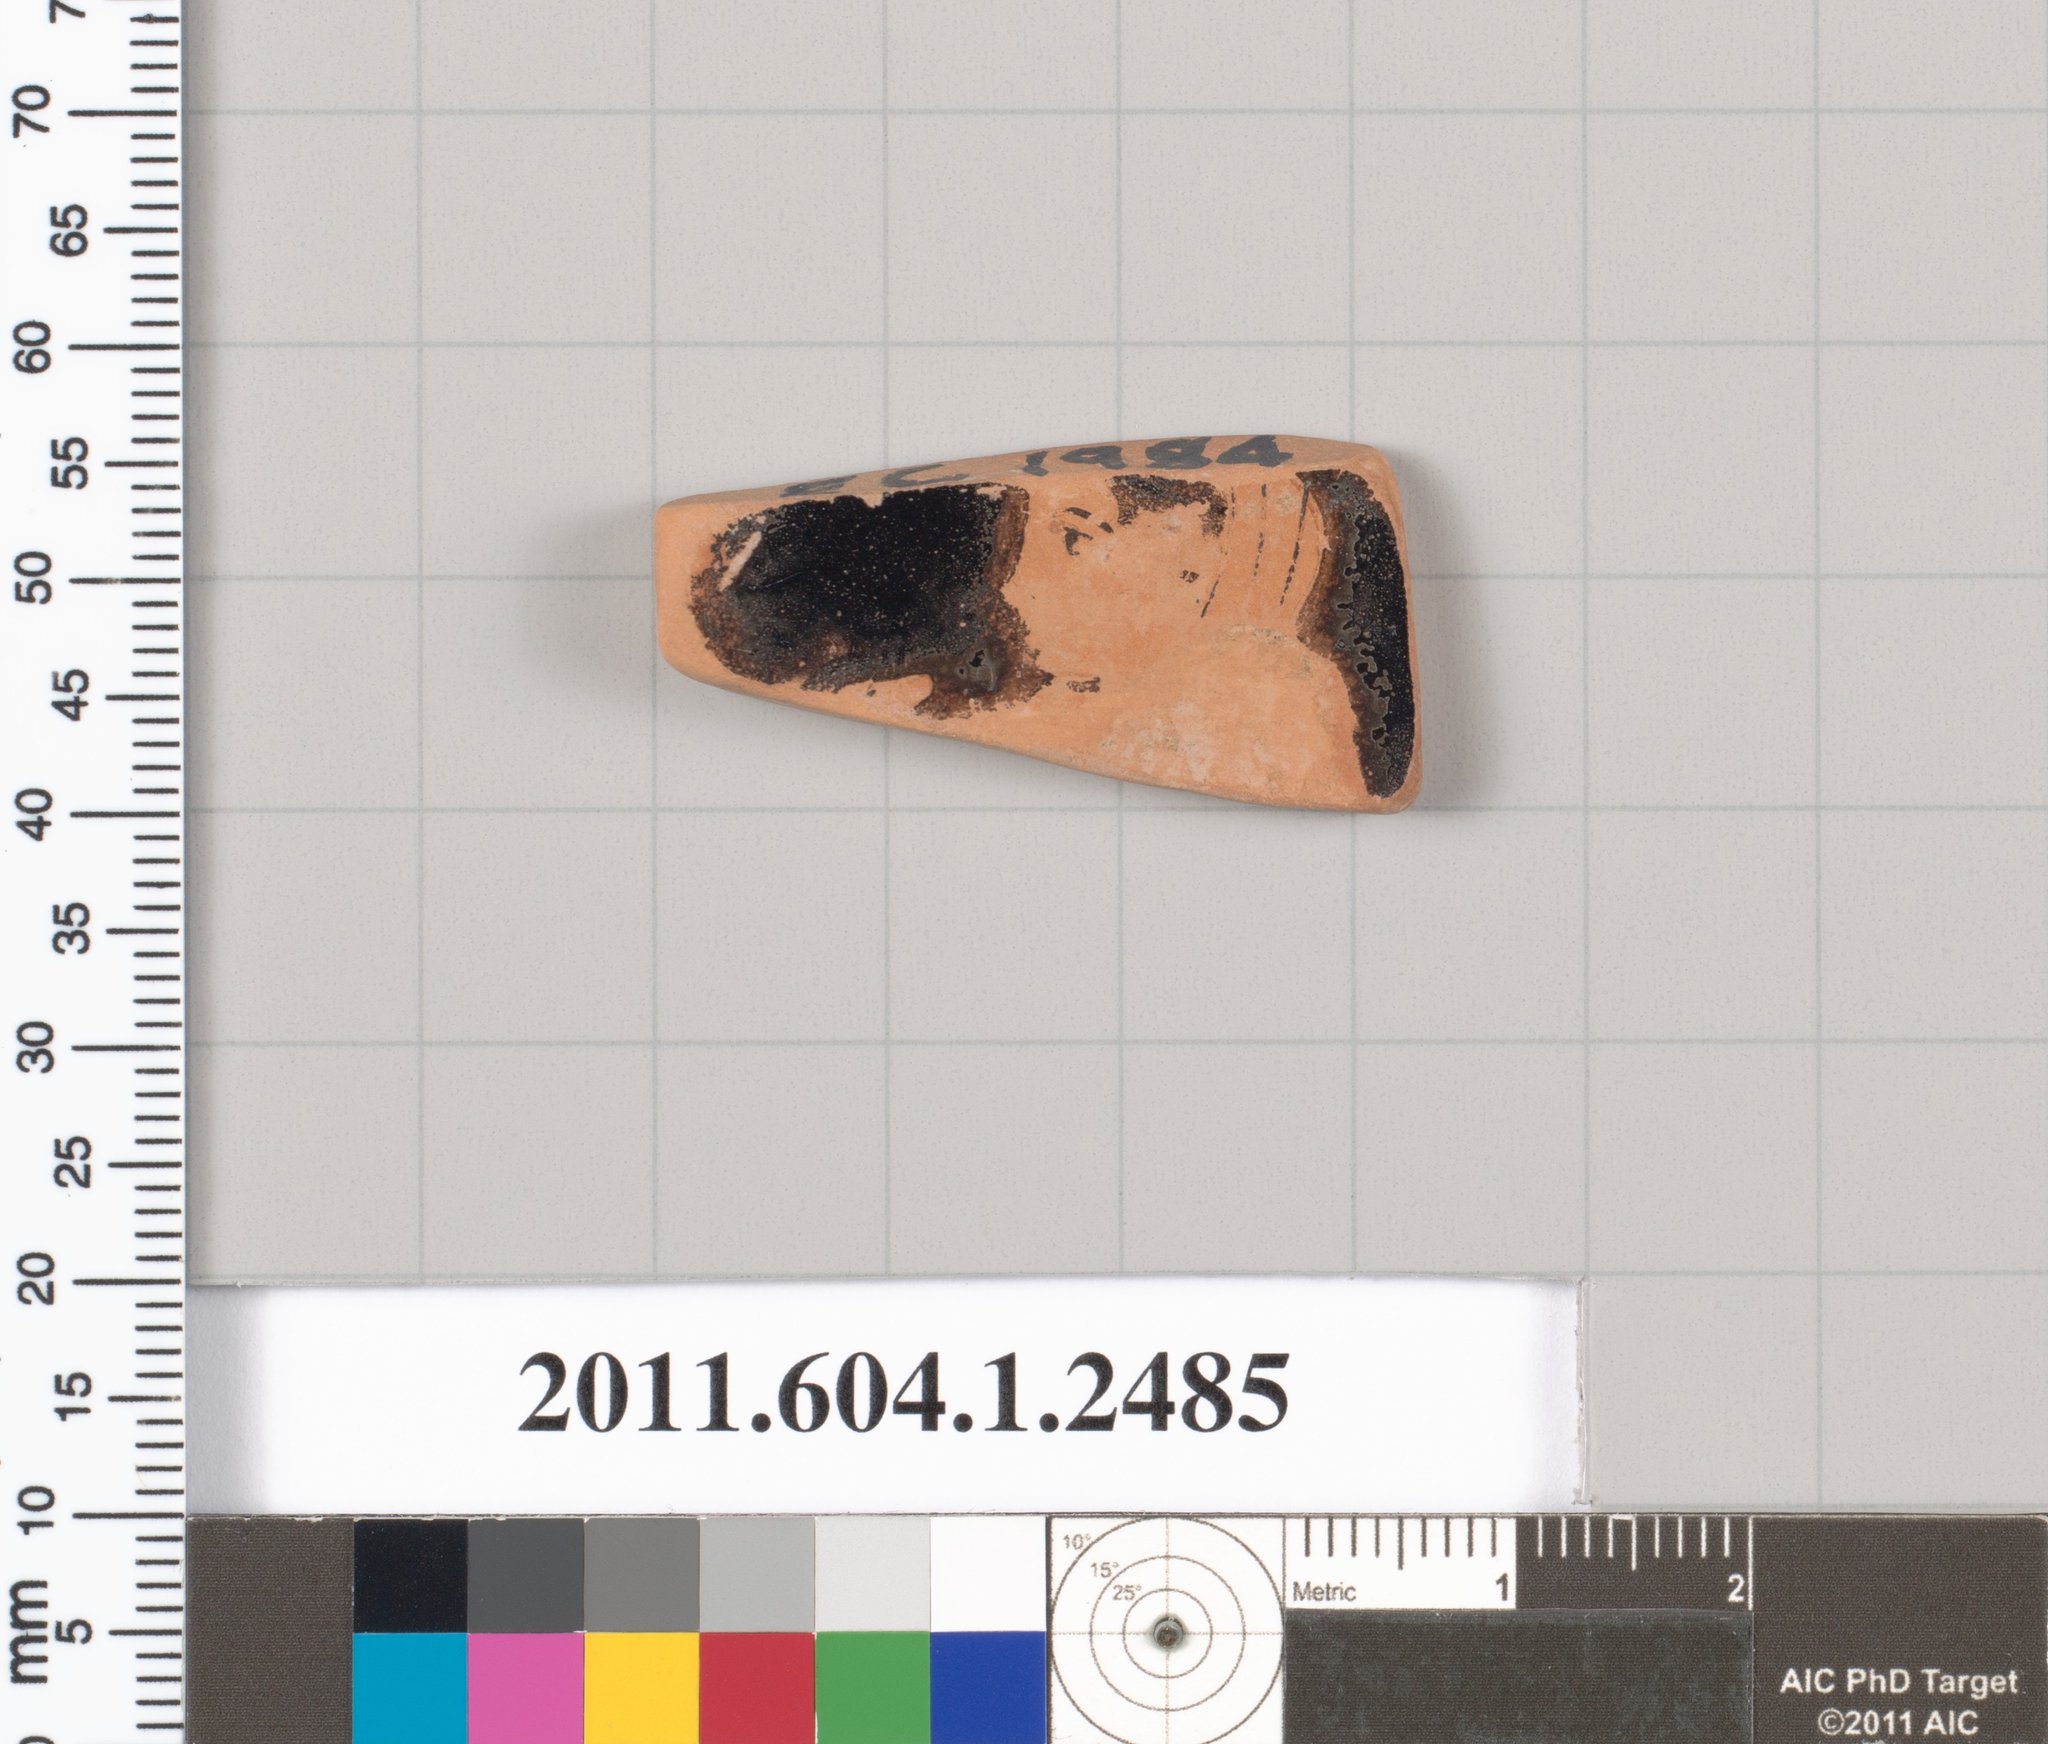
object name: kylix fragment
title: Terracotta fragment of a kylix (drinking cup)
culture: greek, attic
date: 475-451 BCE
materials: terracotta